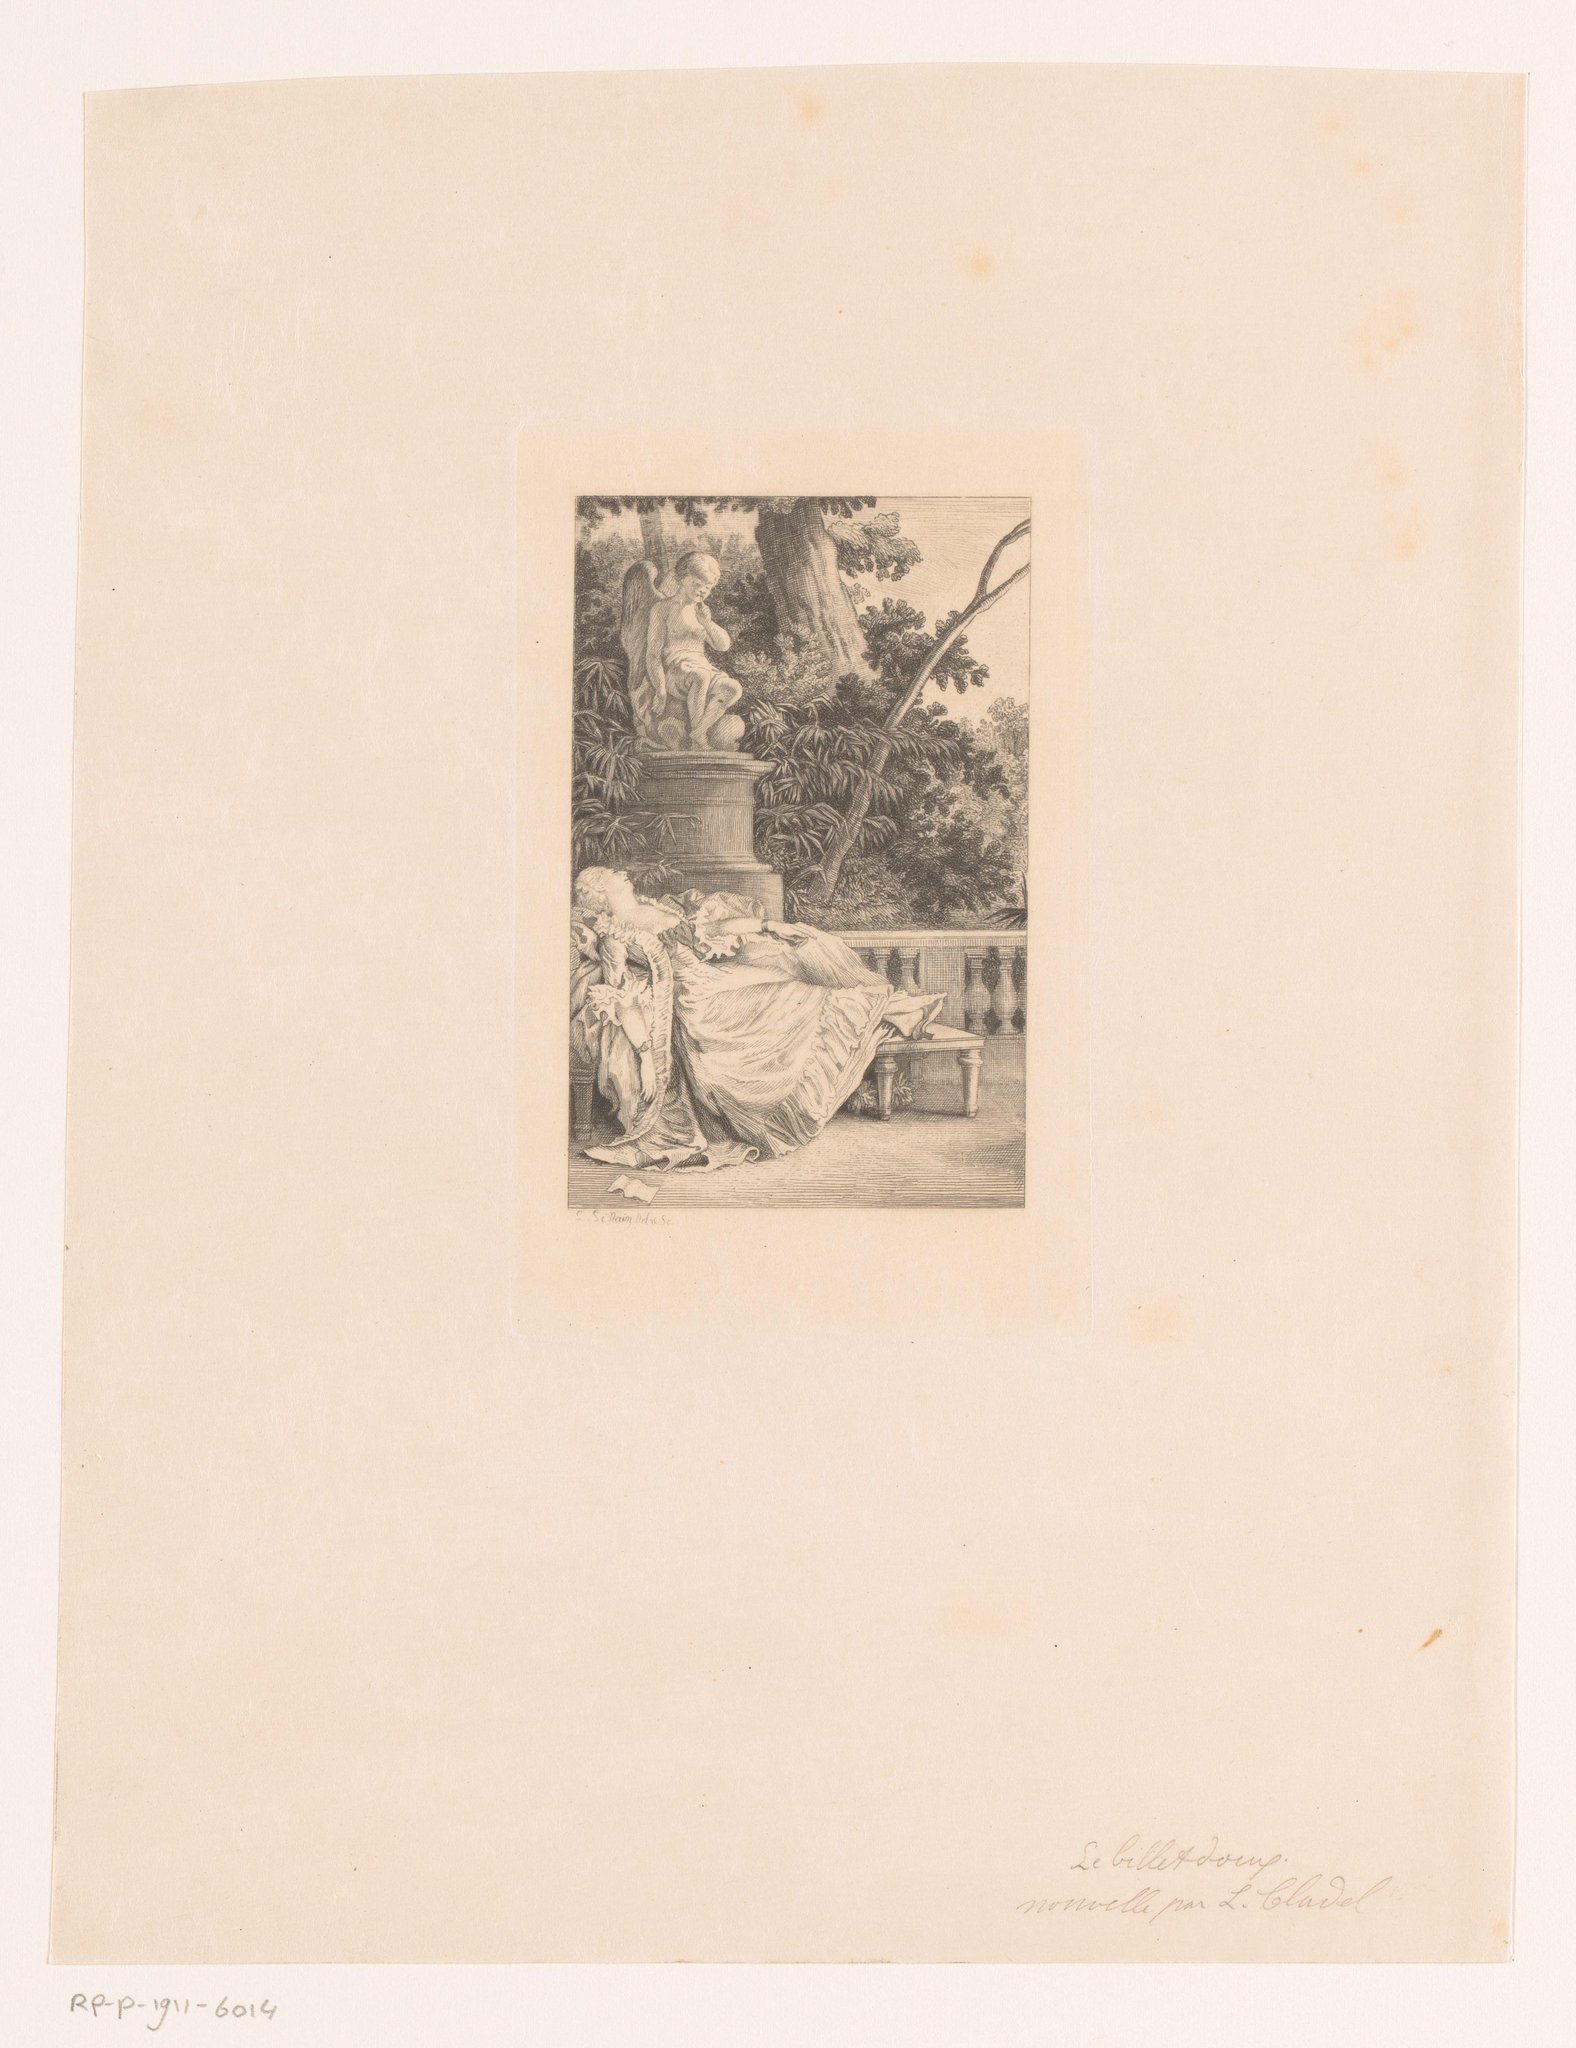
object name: print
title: Vrouw liggend op een bank in een tuin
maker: louis le nain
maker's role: print maker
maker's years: 1851-1939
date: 1861-1911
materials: paper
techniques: etching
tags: garden, lying figure - aa - female human figure, statues, sculptures in garden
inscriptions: collector's mark: Lugt 2228, inscription: ‘Le billet doux. nouvelle par L. Cladel’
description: Links staat een tuinbeeld van Cupido met zijn vinger voor zijn mond. Dit beeld en het briefje op de grond naast de vrouw, verwijzen naar een mogelijke (geheime) liefde van de vrouw.